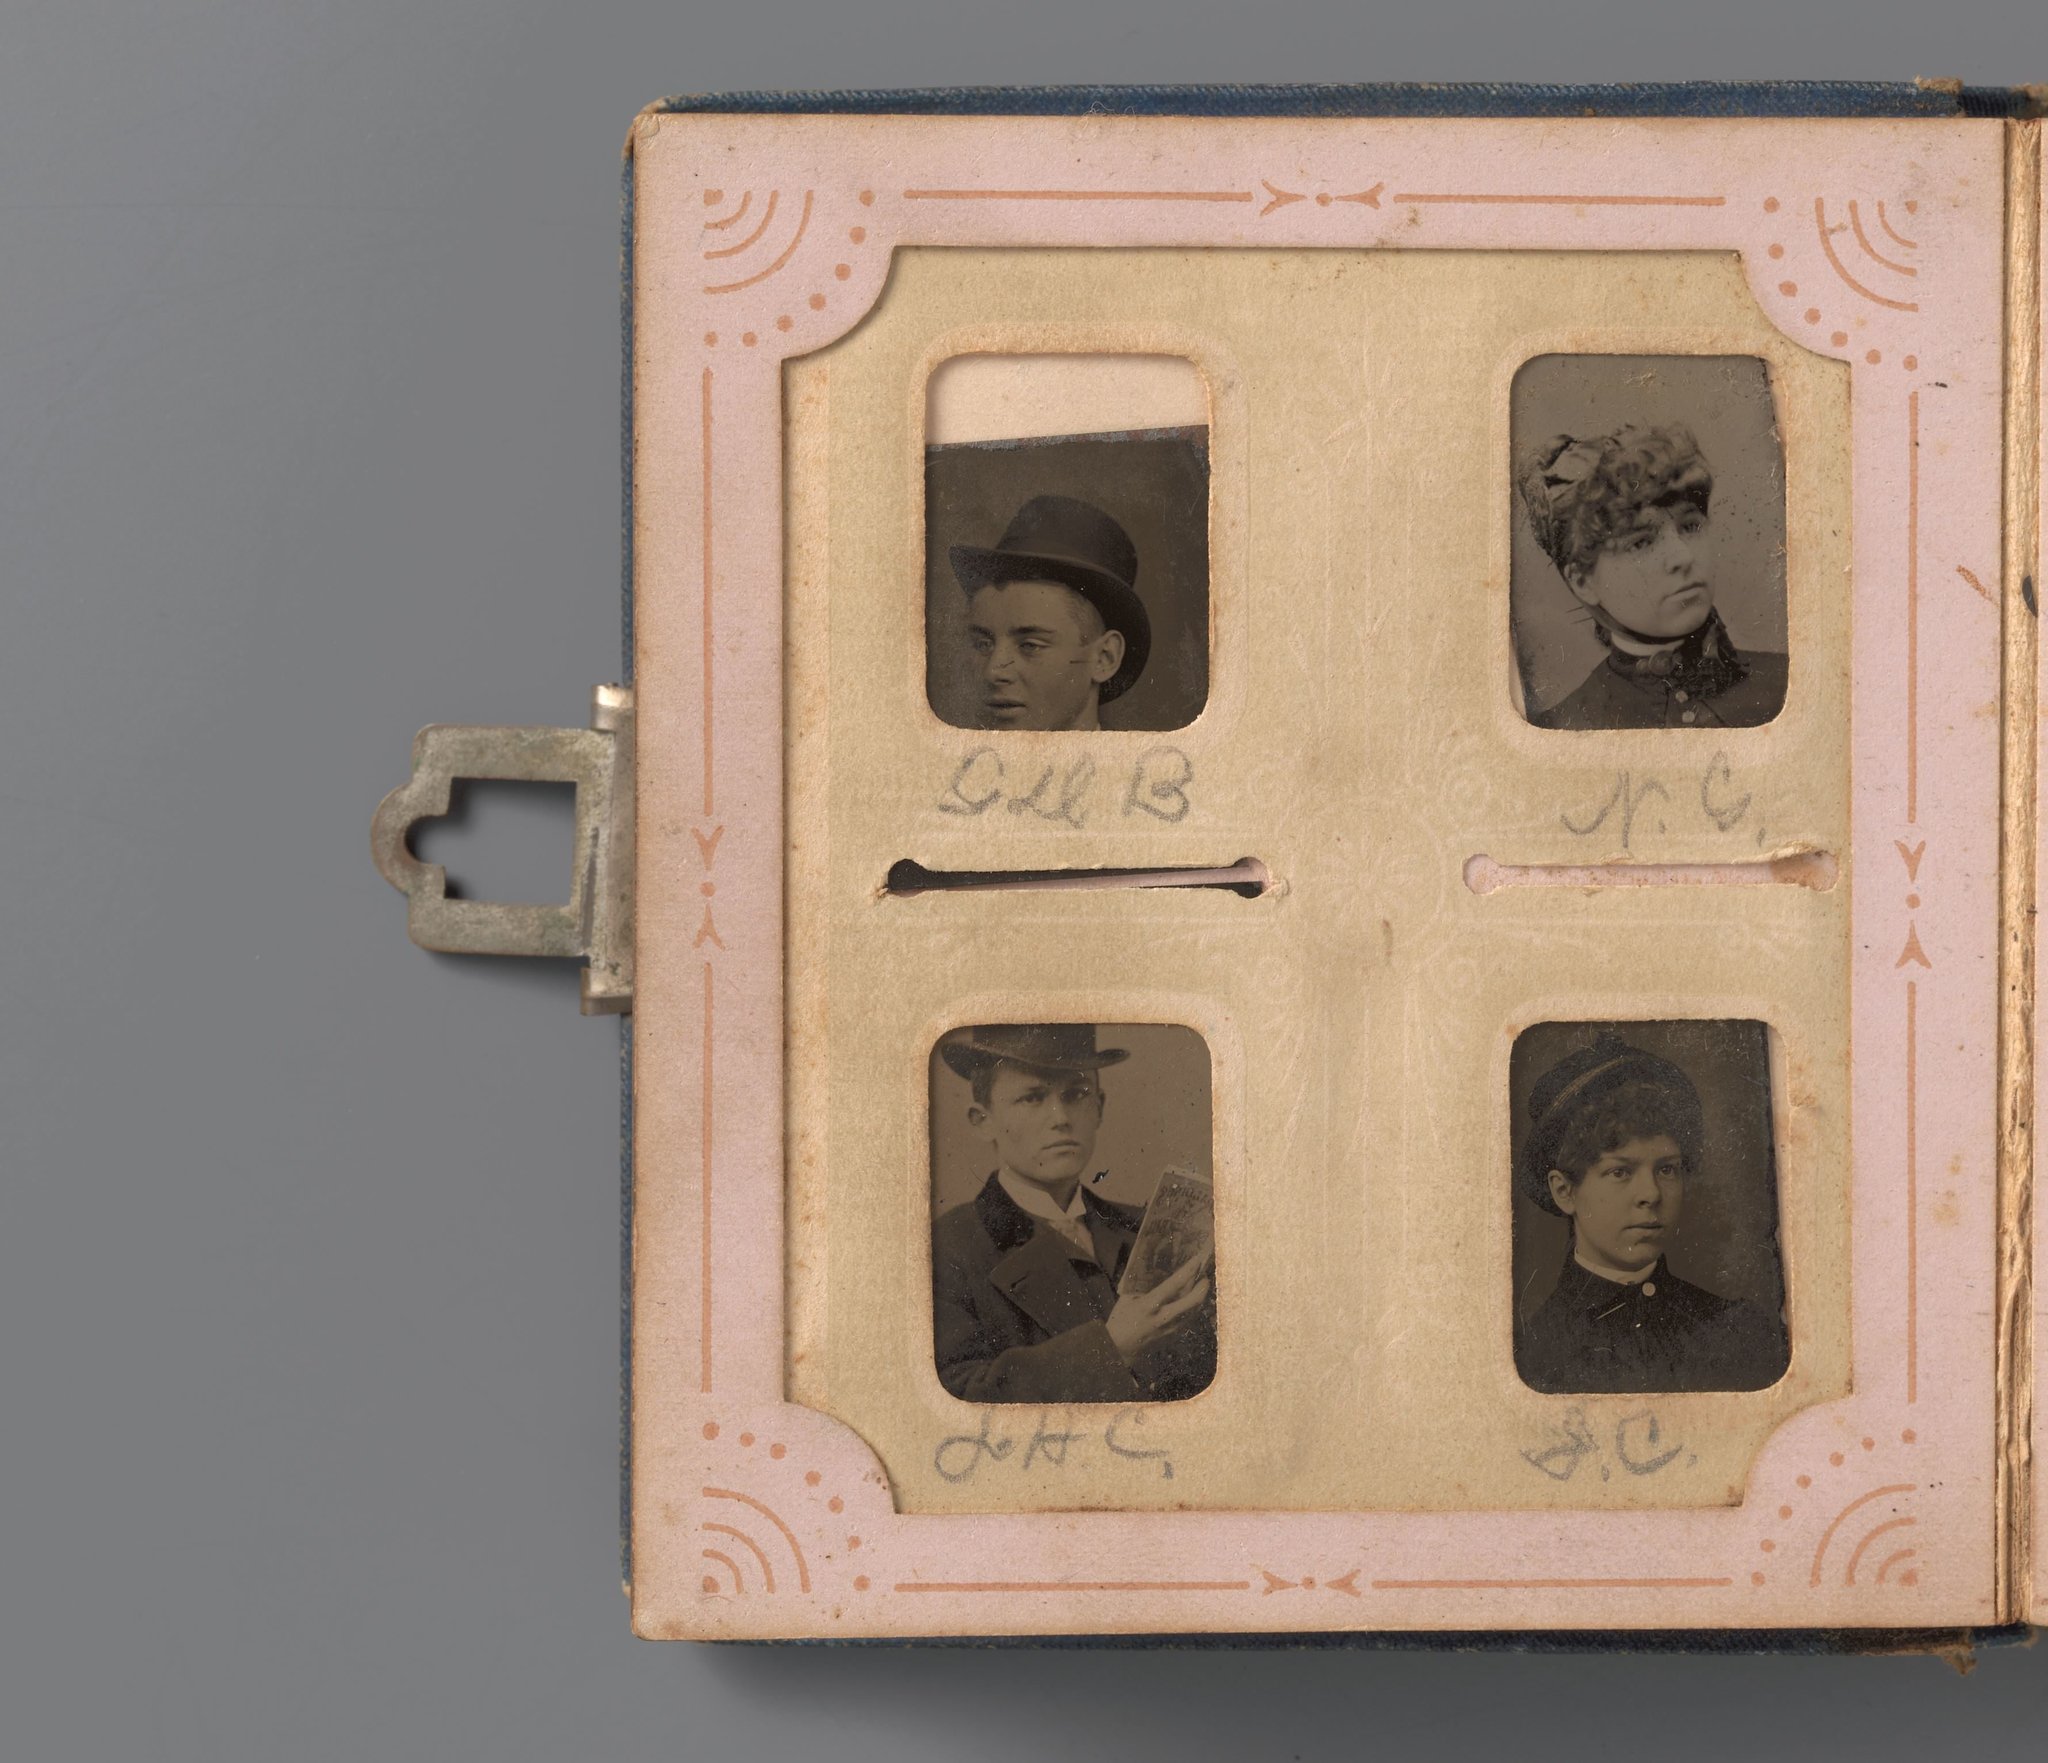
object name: photograph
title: Vier portretten van jonge mannen en jonge vrouwen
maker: Anonymous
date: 1855-1940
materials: cardboard, iron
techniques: ferrotyping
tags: adolescent, young woman, maiden, historical persons - bb - woman, historical persons, youth, adolescent, head-gear: hat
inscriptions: monogram: ‘[G]. C.’, monogram: ‘G [L] B’, monogram: ‘L.H.C.’, monogram: ‘N. G.’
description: Deze foto's maken deel uit van een album.